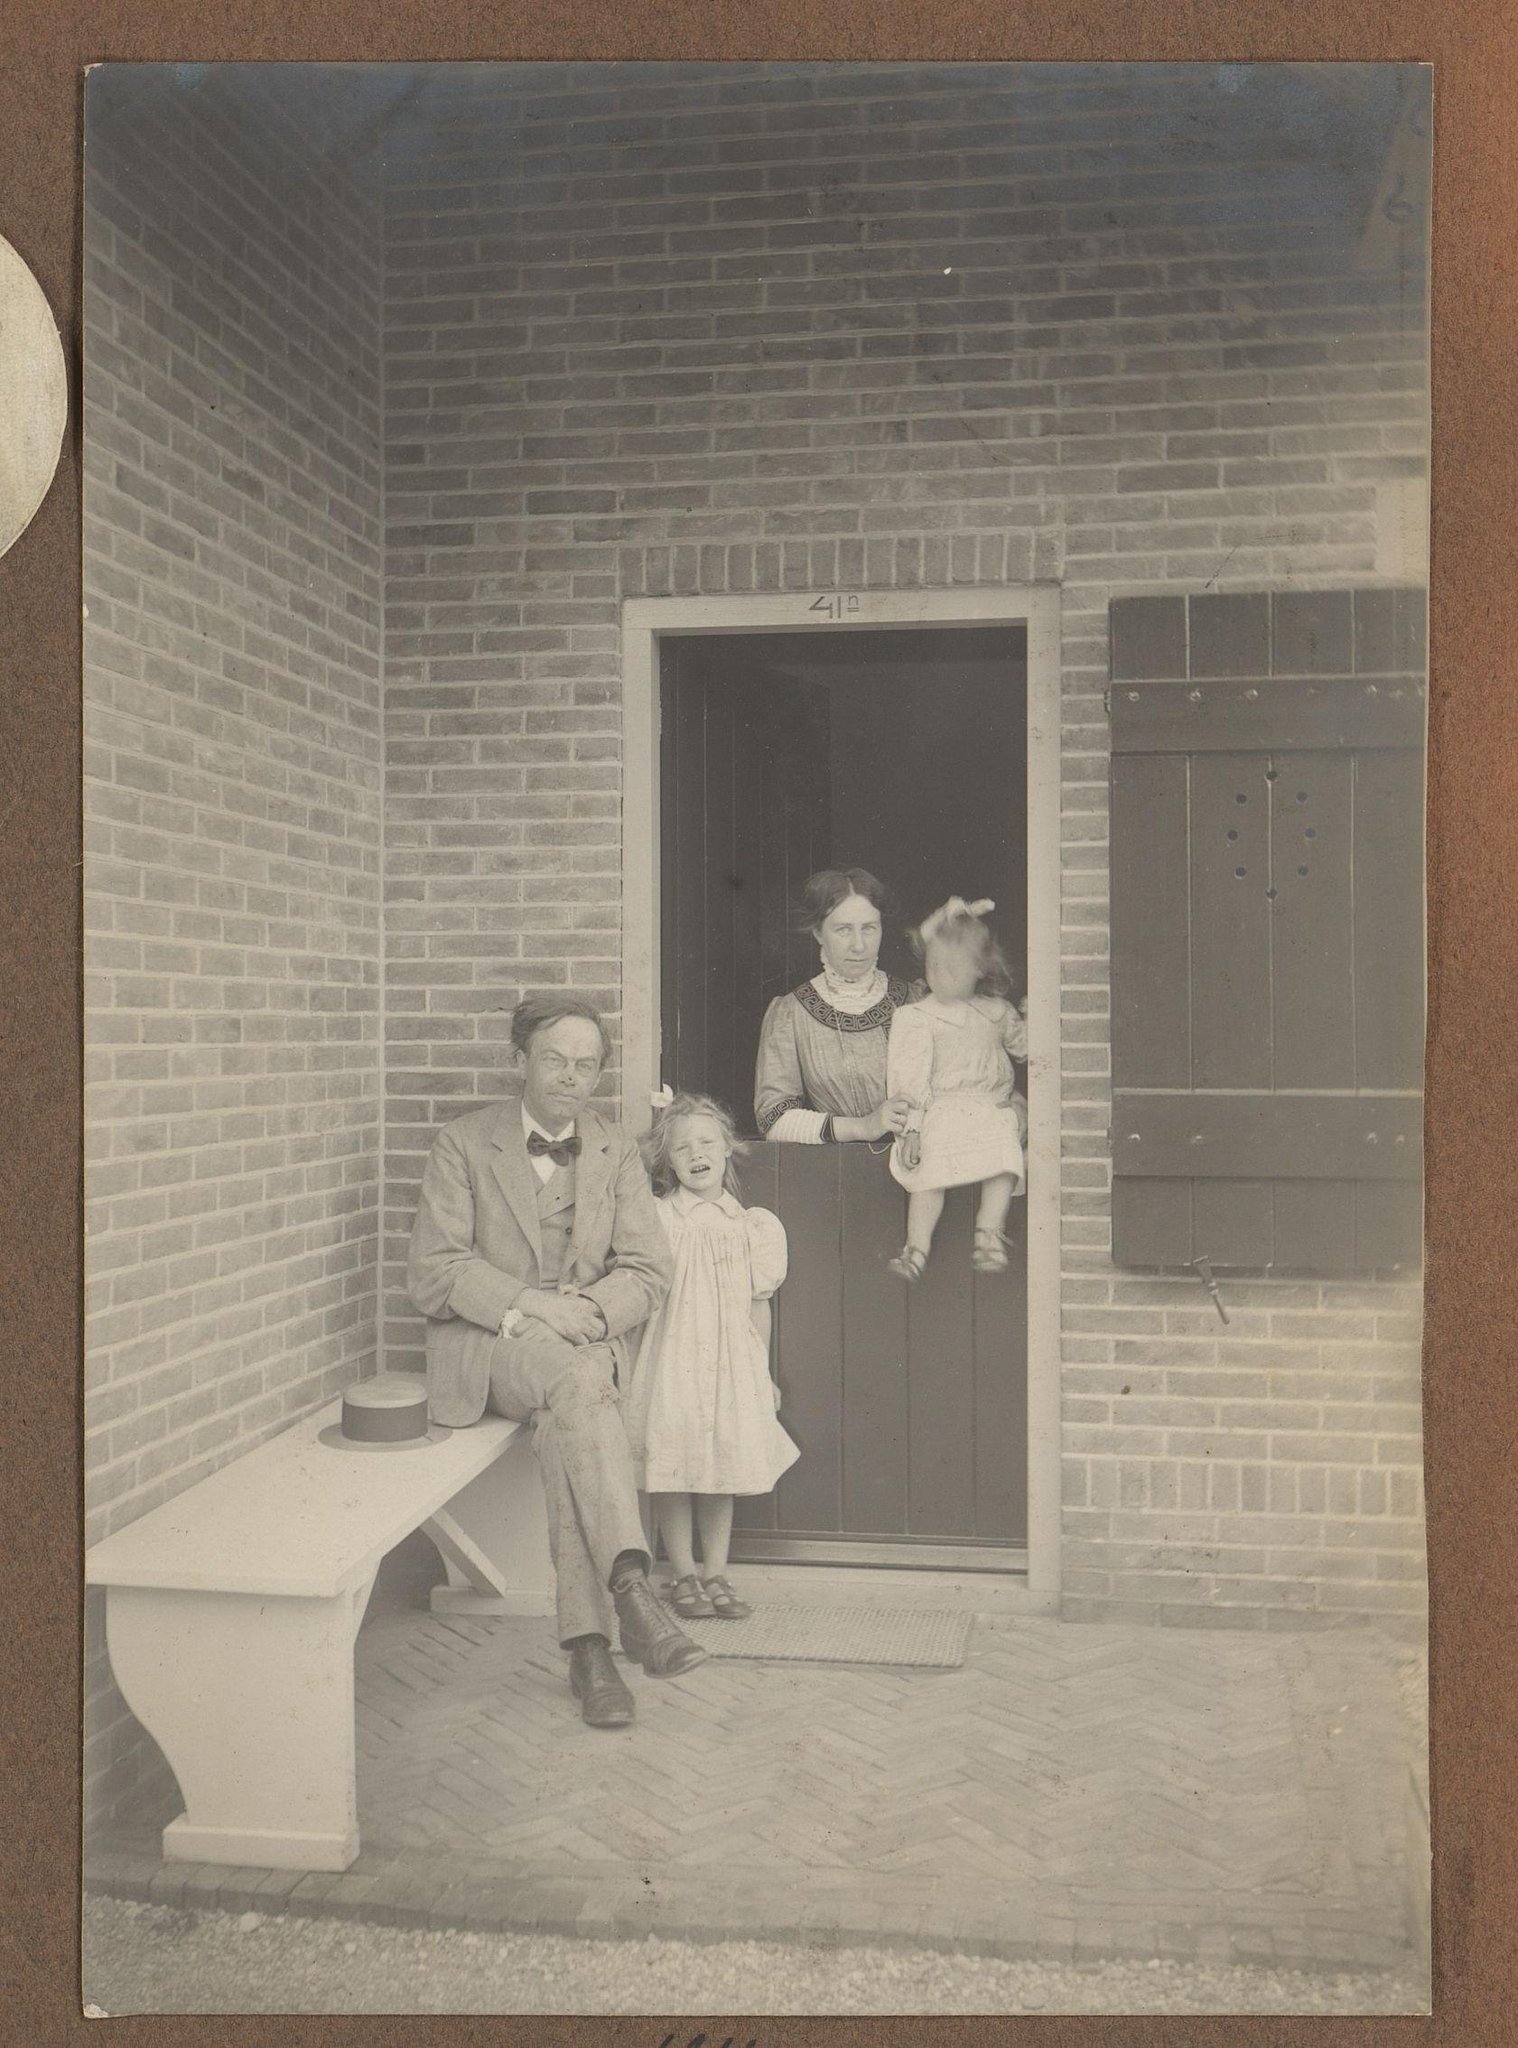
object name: photograph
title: Joanna Diepenbrock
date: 1908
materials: photographic support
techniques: photography, snipping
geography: netherlands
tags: amsterdam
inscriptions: date: ‘1906’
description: Foto op bruin albumblad 19 van familiealbum van Alphons Diepenbrock.